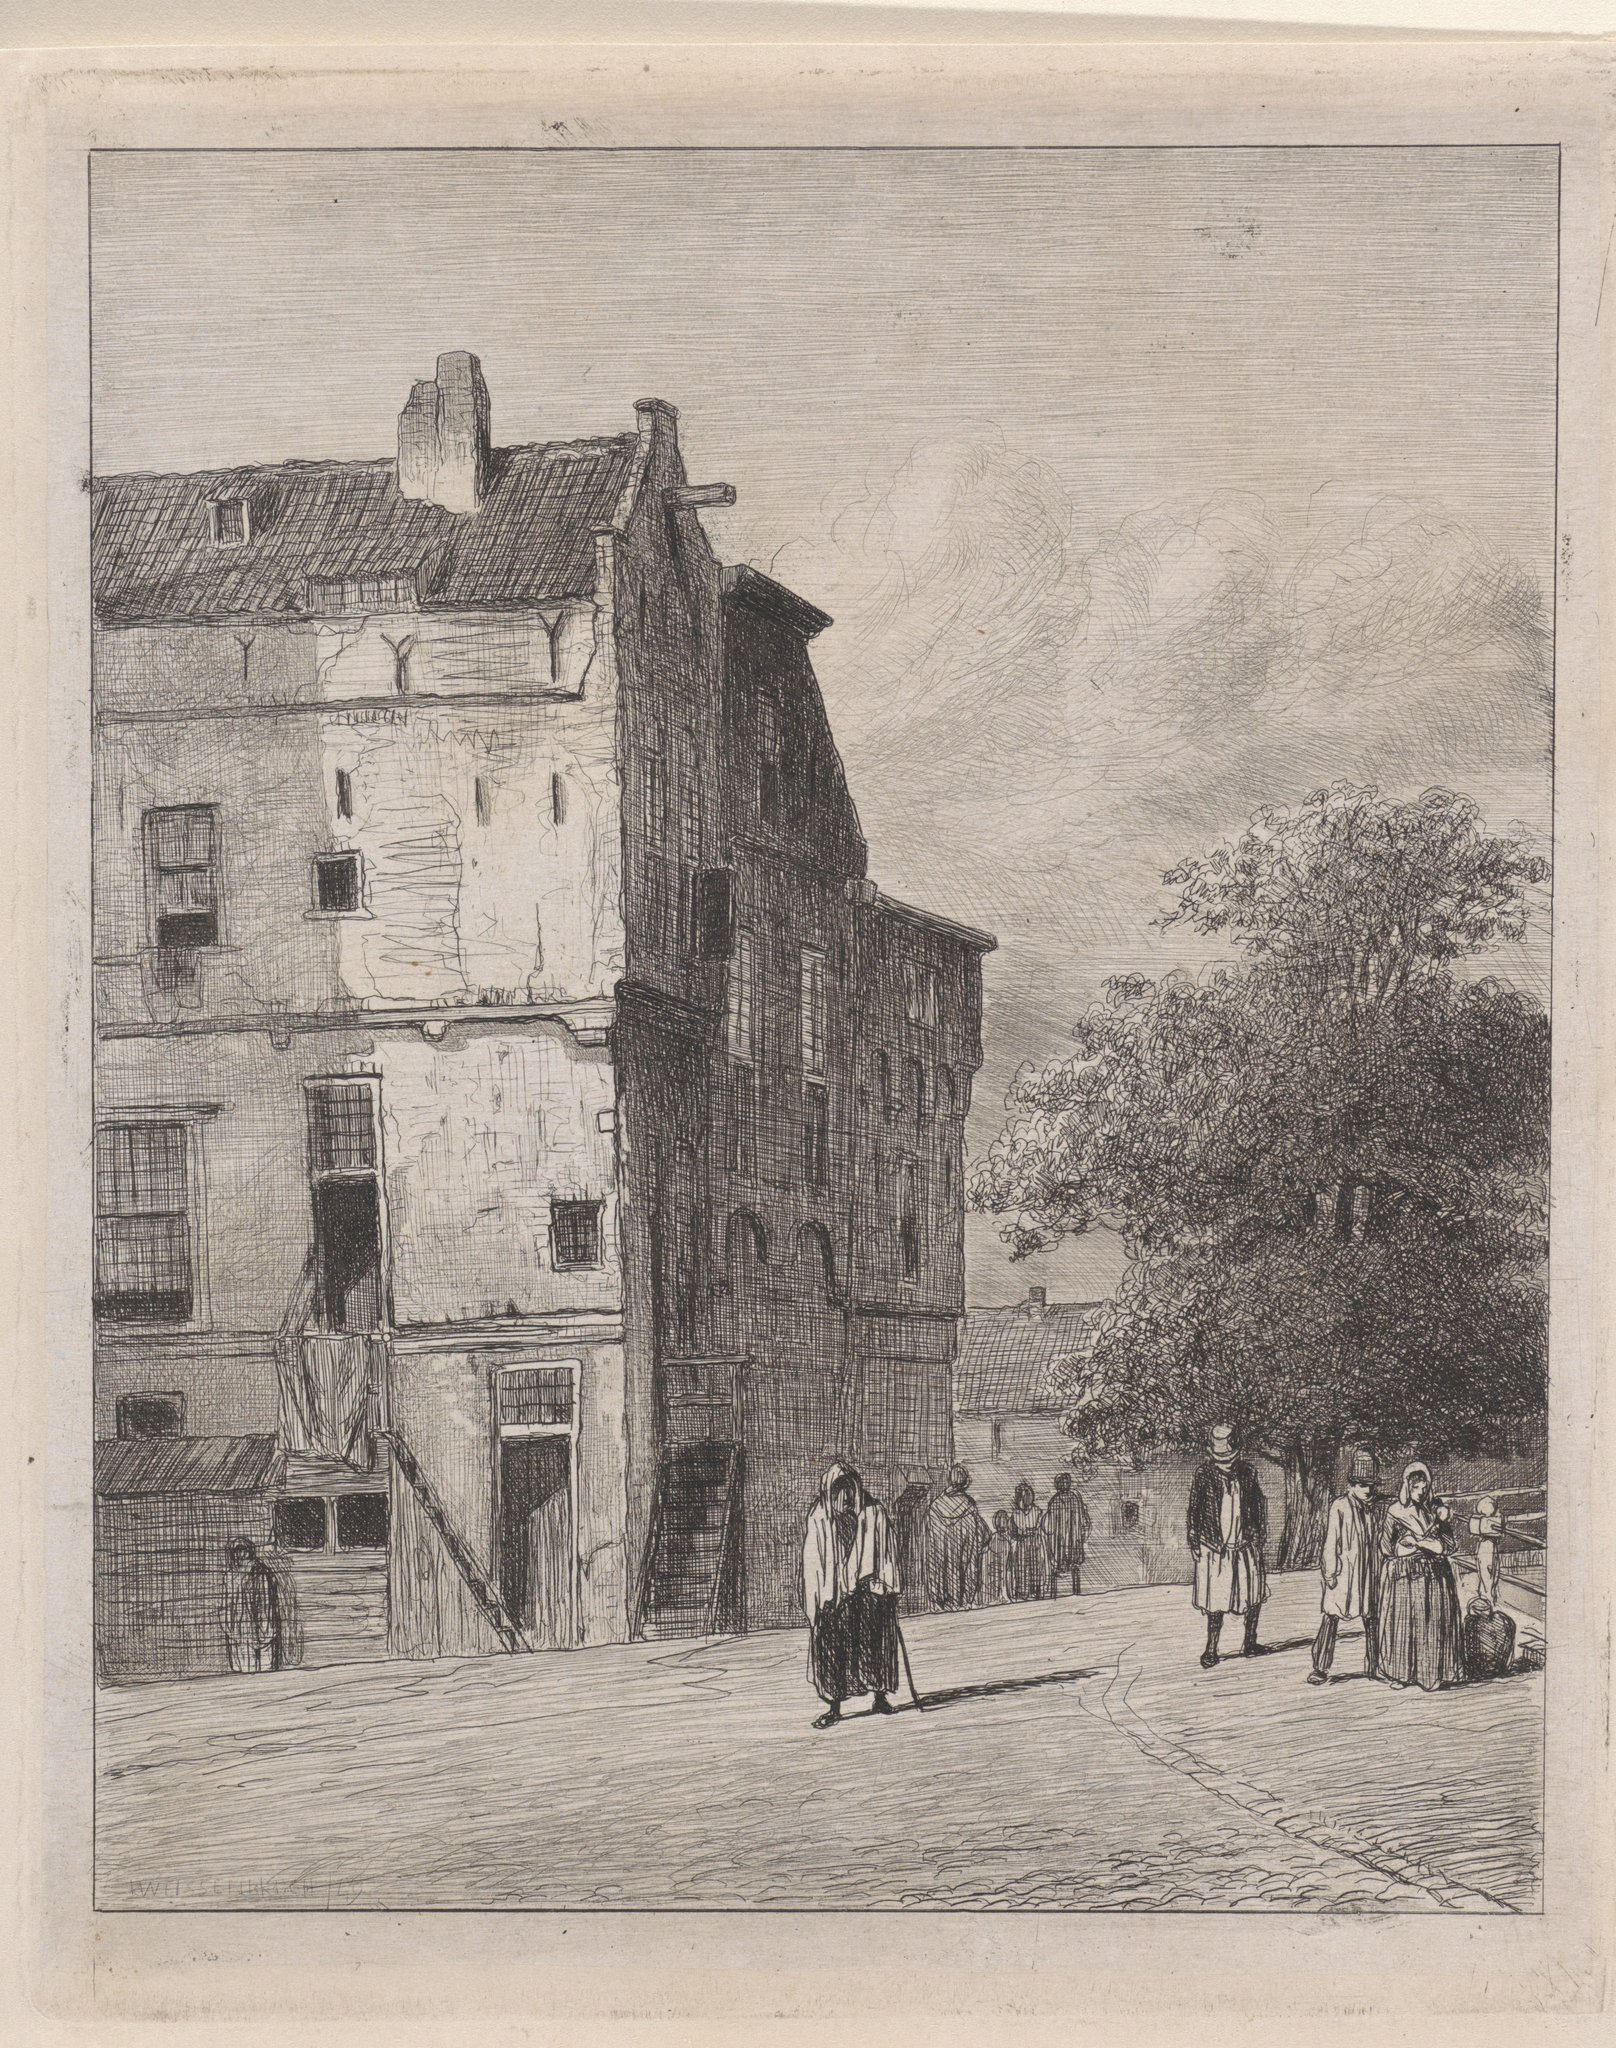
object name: print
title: Gezicht op een straat te Amsterdam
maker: jan weissenbruch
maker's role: painter, print maker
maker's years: 1822-1880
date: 1849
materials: paper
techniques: etching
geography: amsterdam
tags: urban housing, city-view, and landscape with man-made constructions, trees, adult woman, adult man, walking, amsterdam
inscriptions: collector's mark: Lugt 2228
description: Enkele figuren lopen over straat. Links en in de verte staan een paar huizen. Rechts zijn bomen te zien.